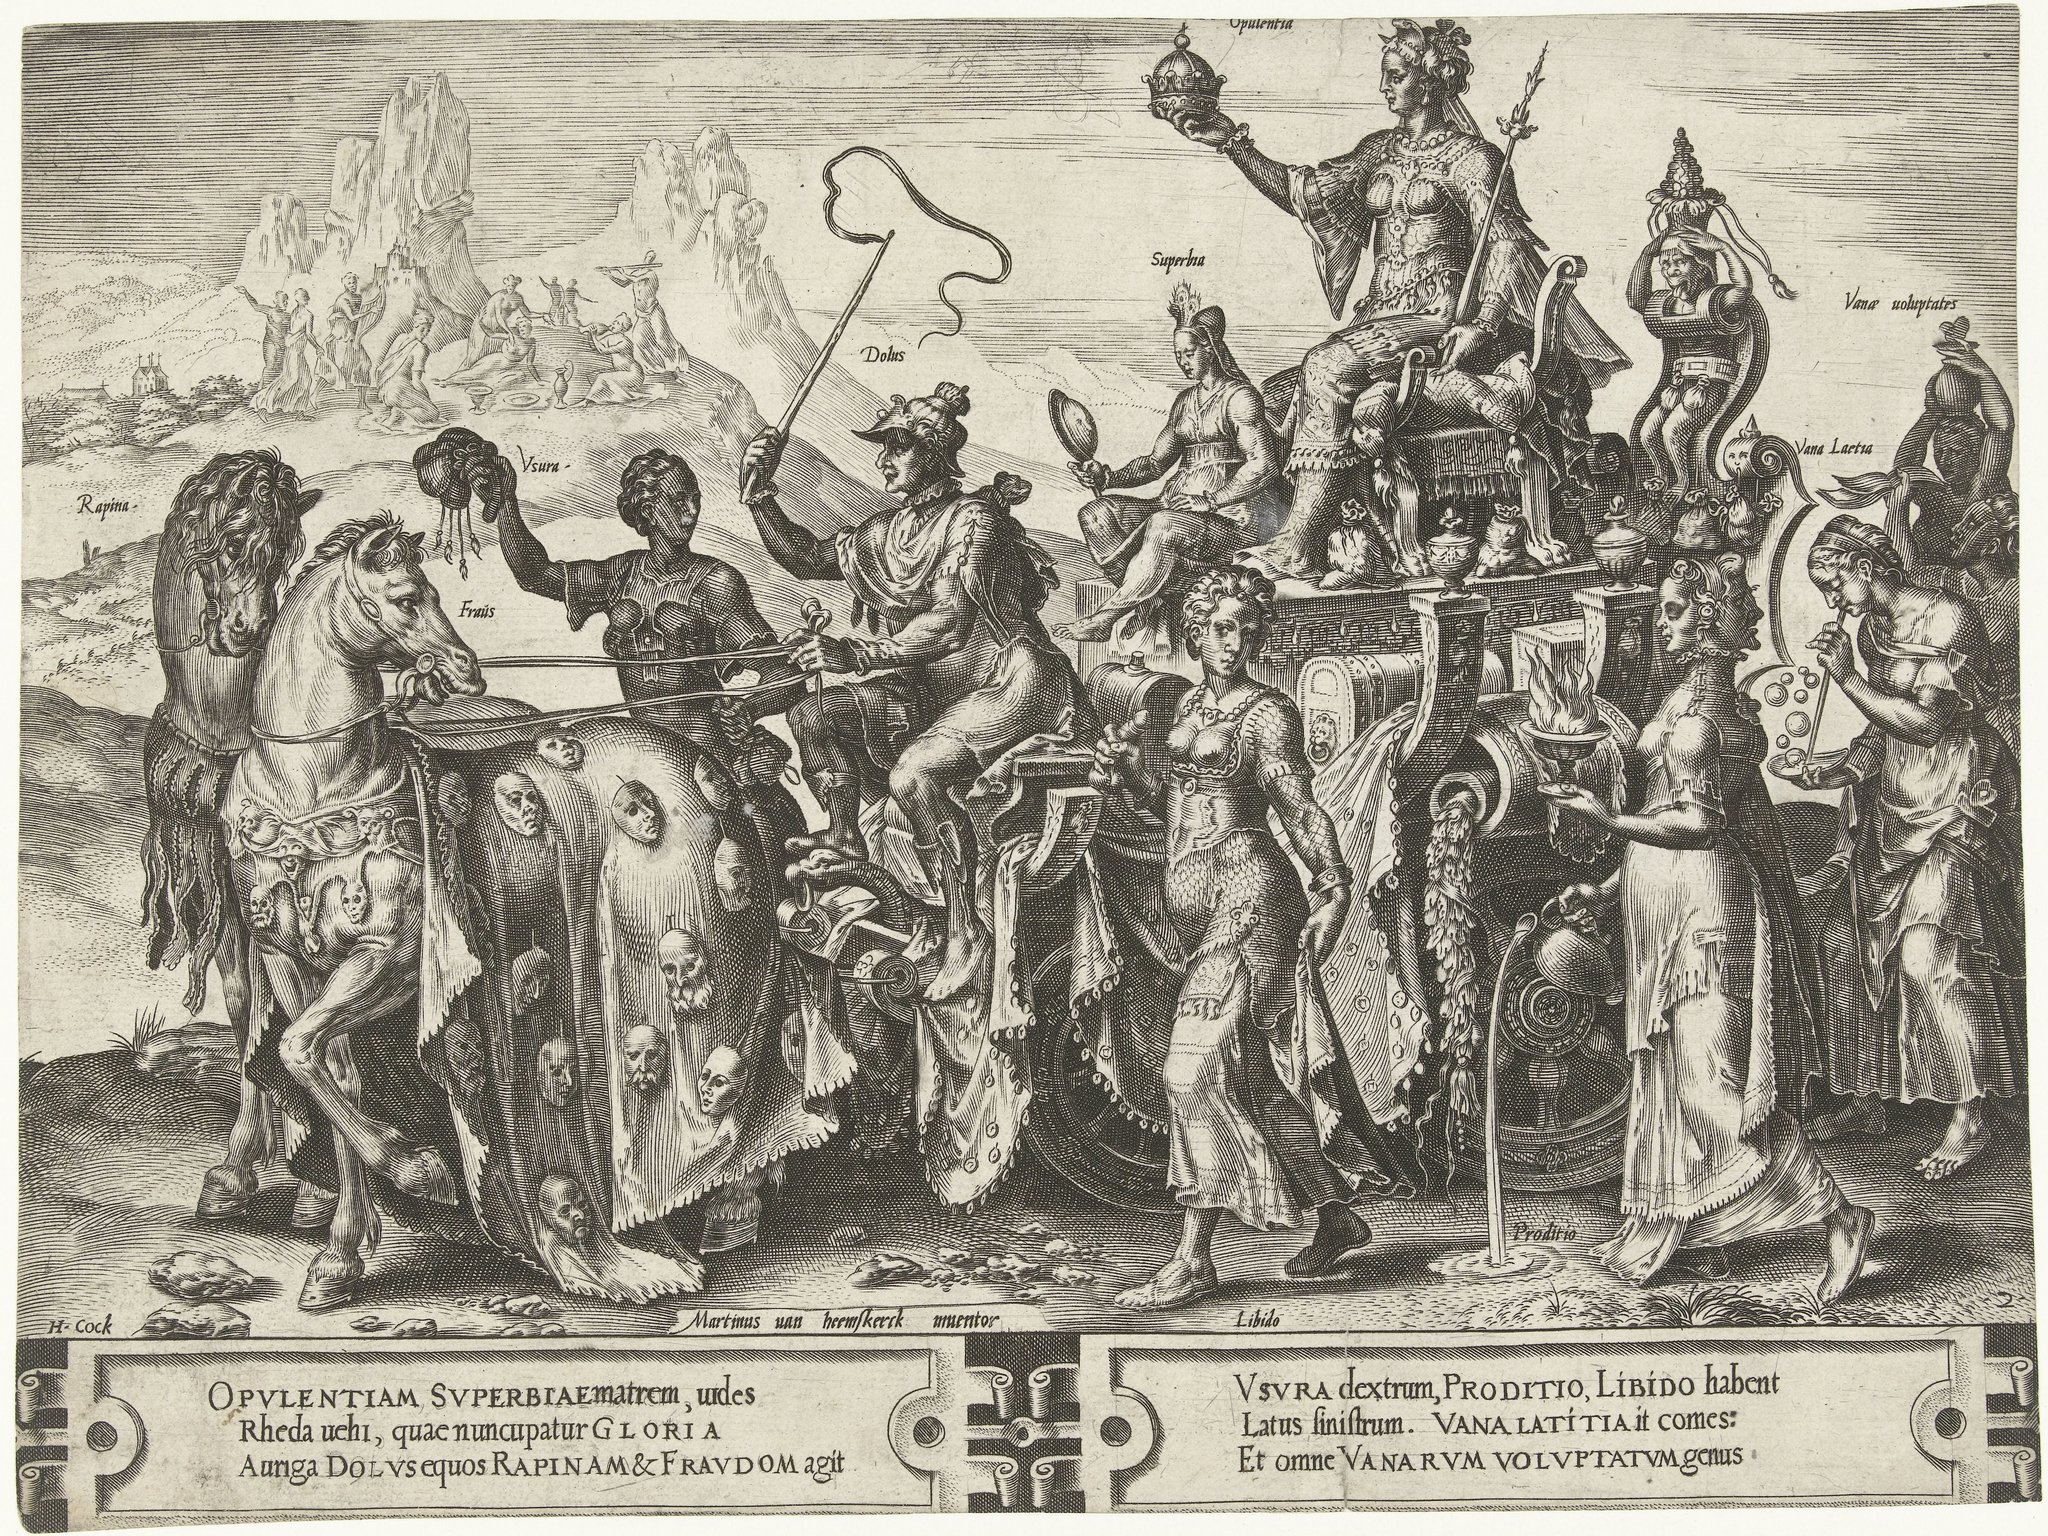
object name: print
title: Triomfwagen met Rijkdom (Opulentia)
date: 1564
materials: paper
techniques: engraving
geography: antwerp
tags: vicissitudes of life (+ allegorical scene, i.e. two or more personifications involved in an action), chariot, triumphal car, wealth, opulence; 'opulenza', 'richezza' (ripa)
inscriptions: collector's mark: Lugt 2228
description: Op een triomfwagen zit de personificatie van de rijkdom (Opulentia) met kroon en scepter, zakken met geld onder haar troon. De wagen wordt begeleidt door personificaties van Woeker (Usura), Lust (Libido), Verraad (Proditio) en List (Dolus) die ervoor zorgen dat rijkdom tot stand komt. Prent uit een serie van negen prenten met triomfwagens uit de Antwerpse Besnijdenis-ommegang van 1561. De personificaties op de wagens verbeelden samen de kringloop van het menselijk handelen.